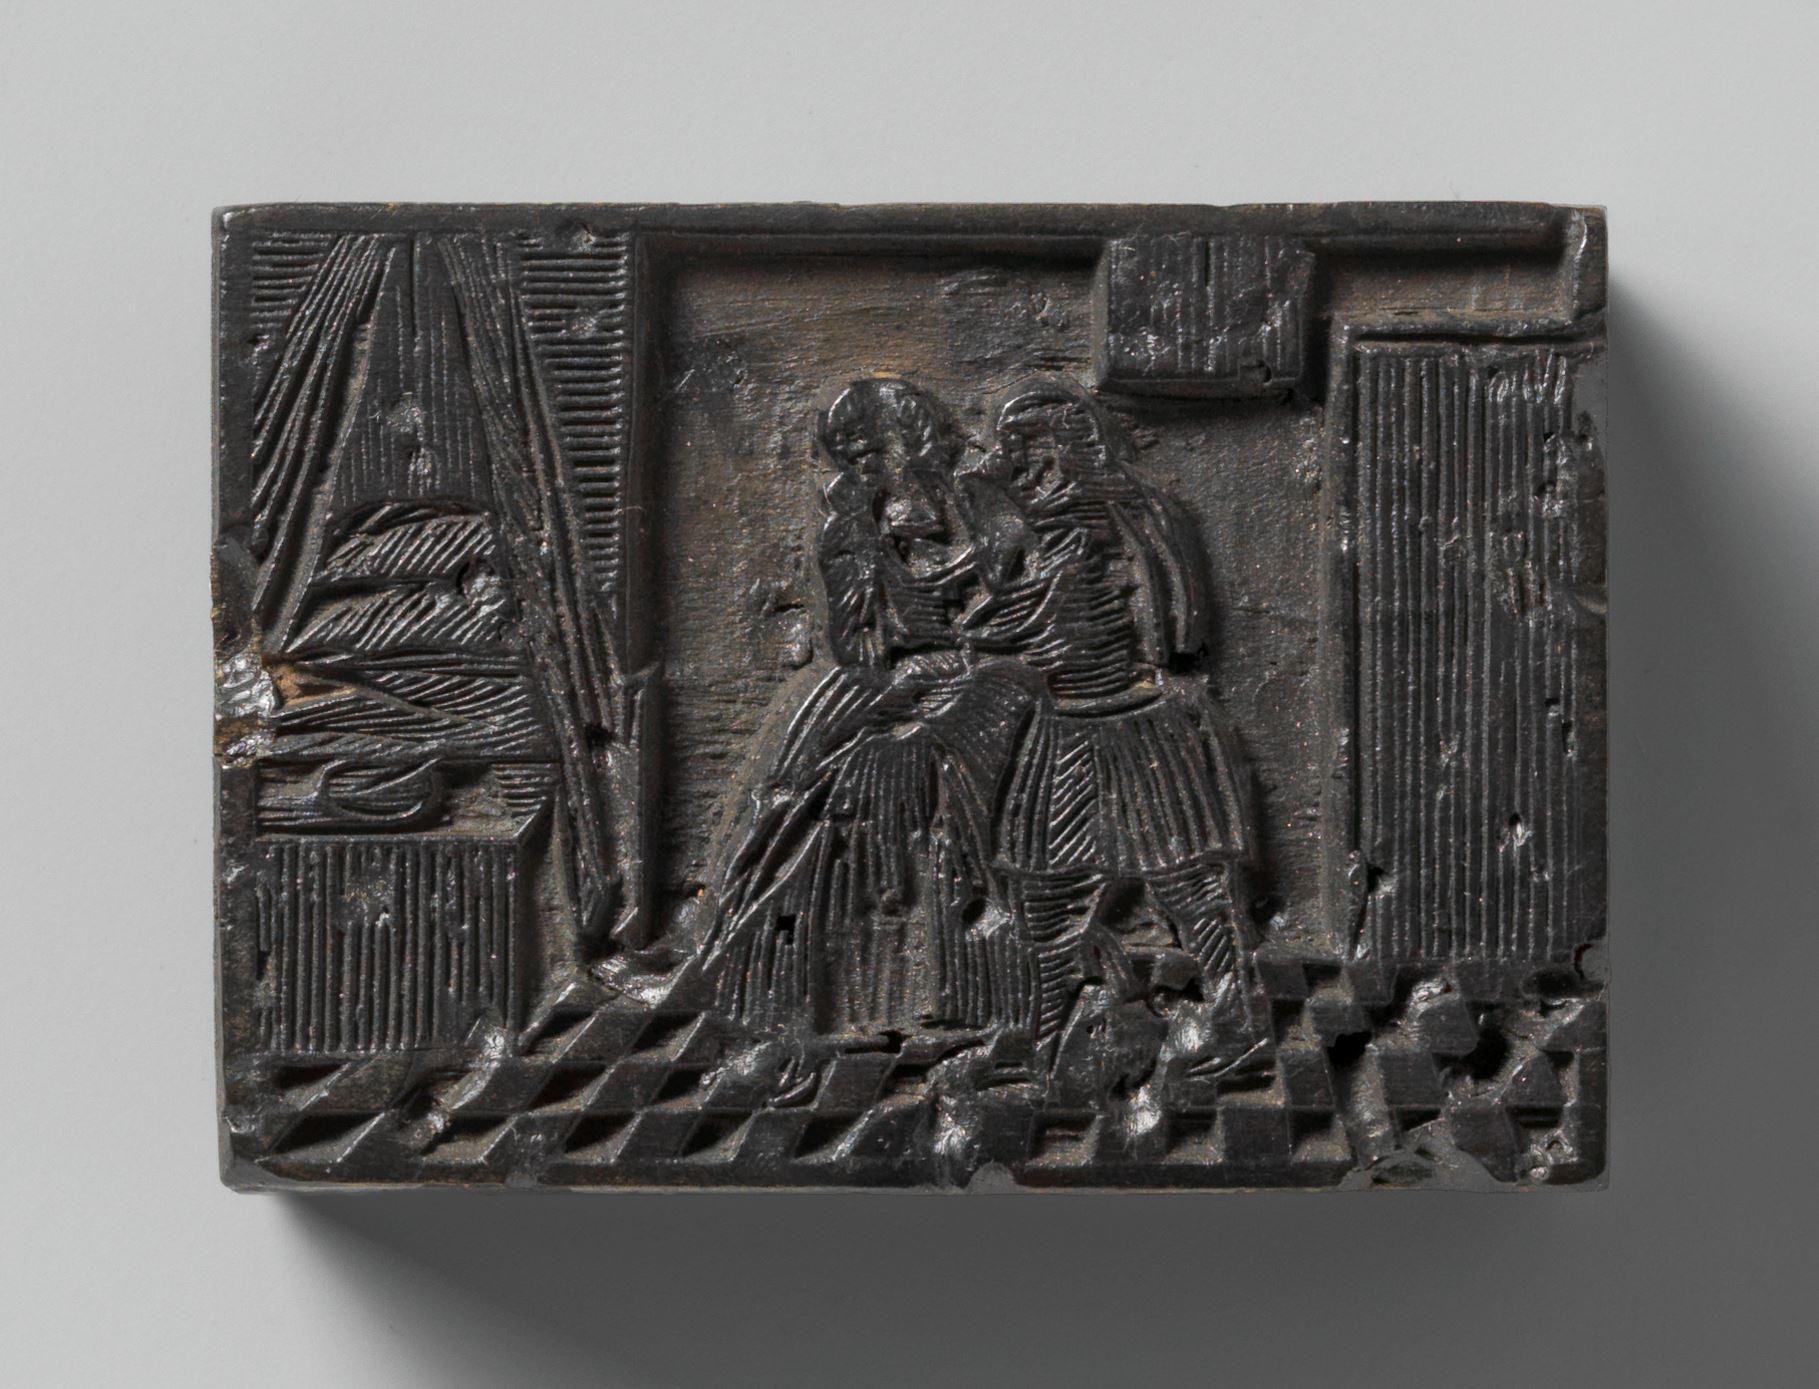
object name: wood block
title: Man en vrouw in slaapvertrek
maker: Anonymous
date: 1600-1799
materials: wood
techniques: woodcut